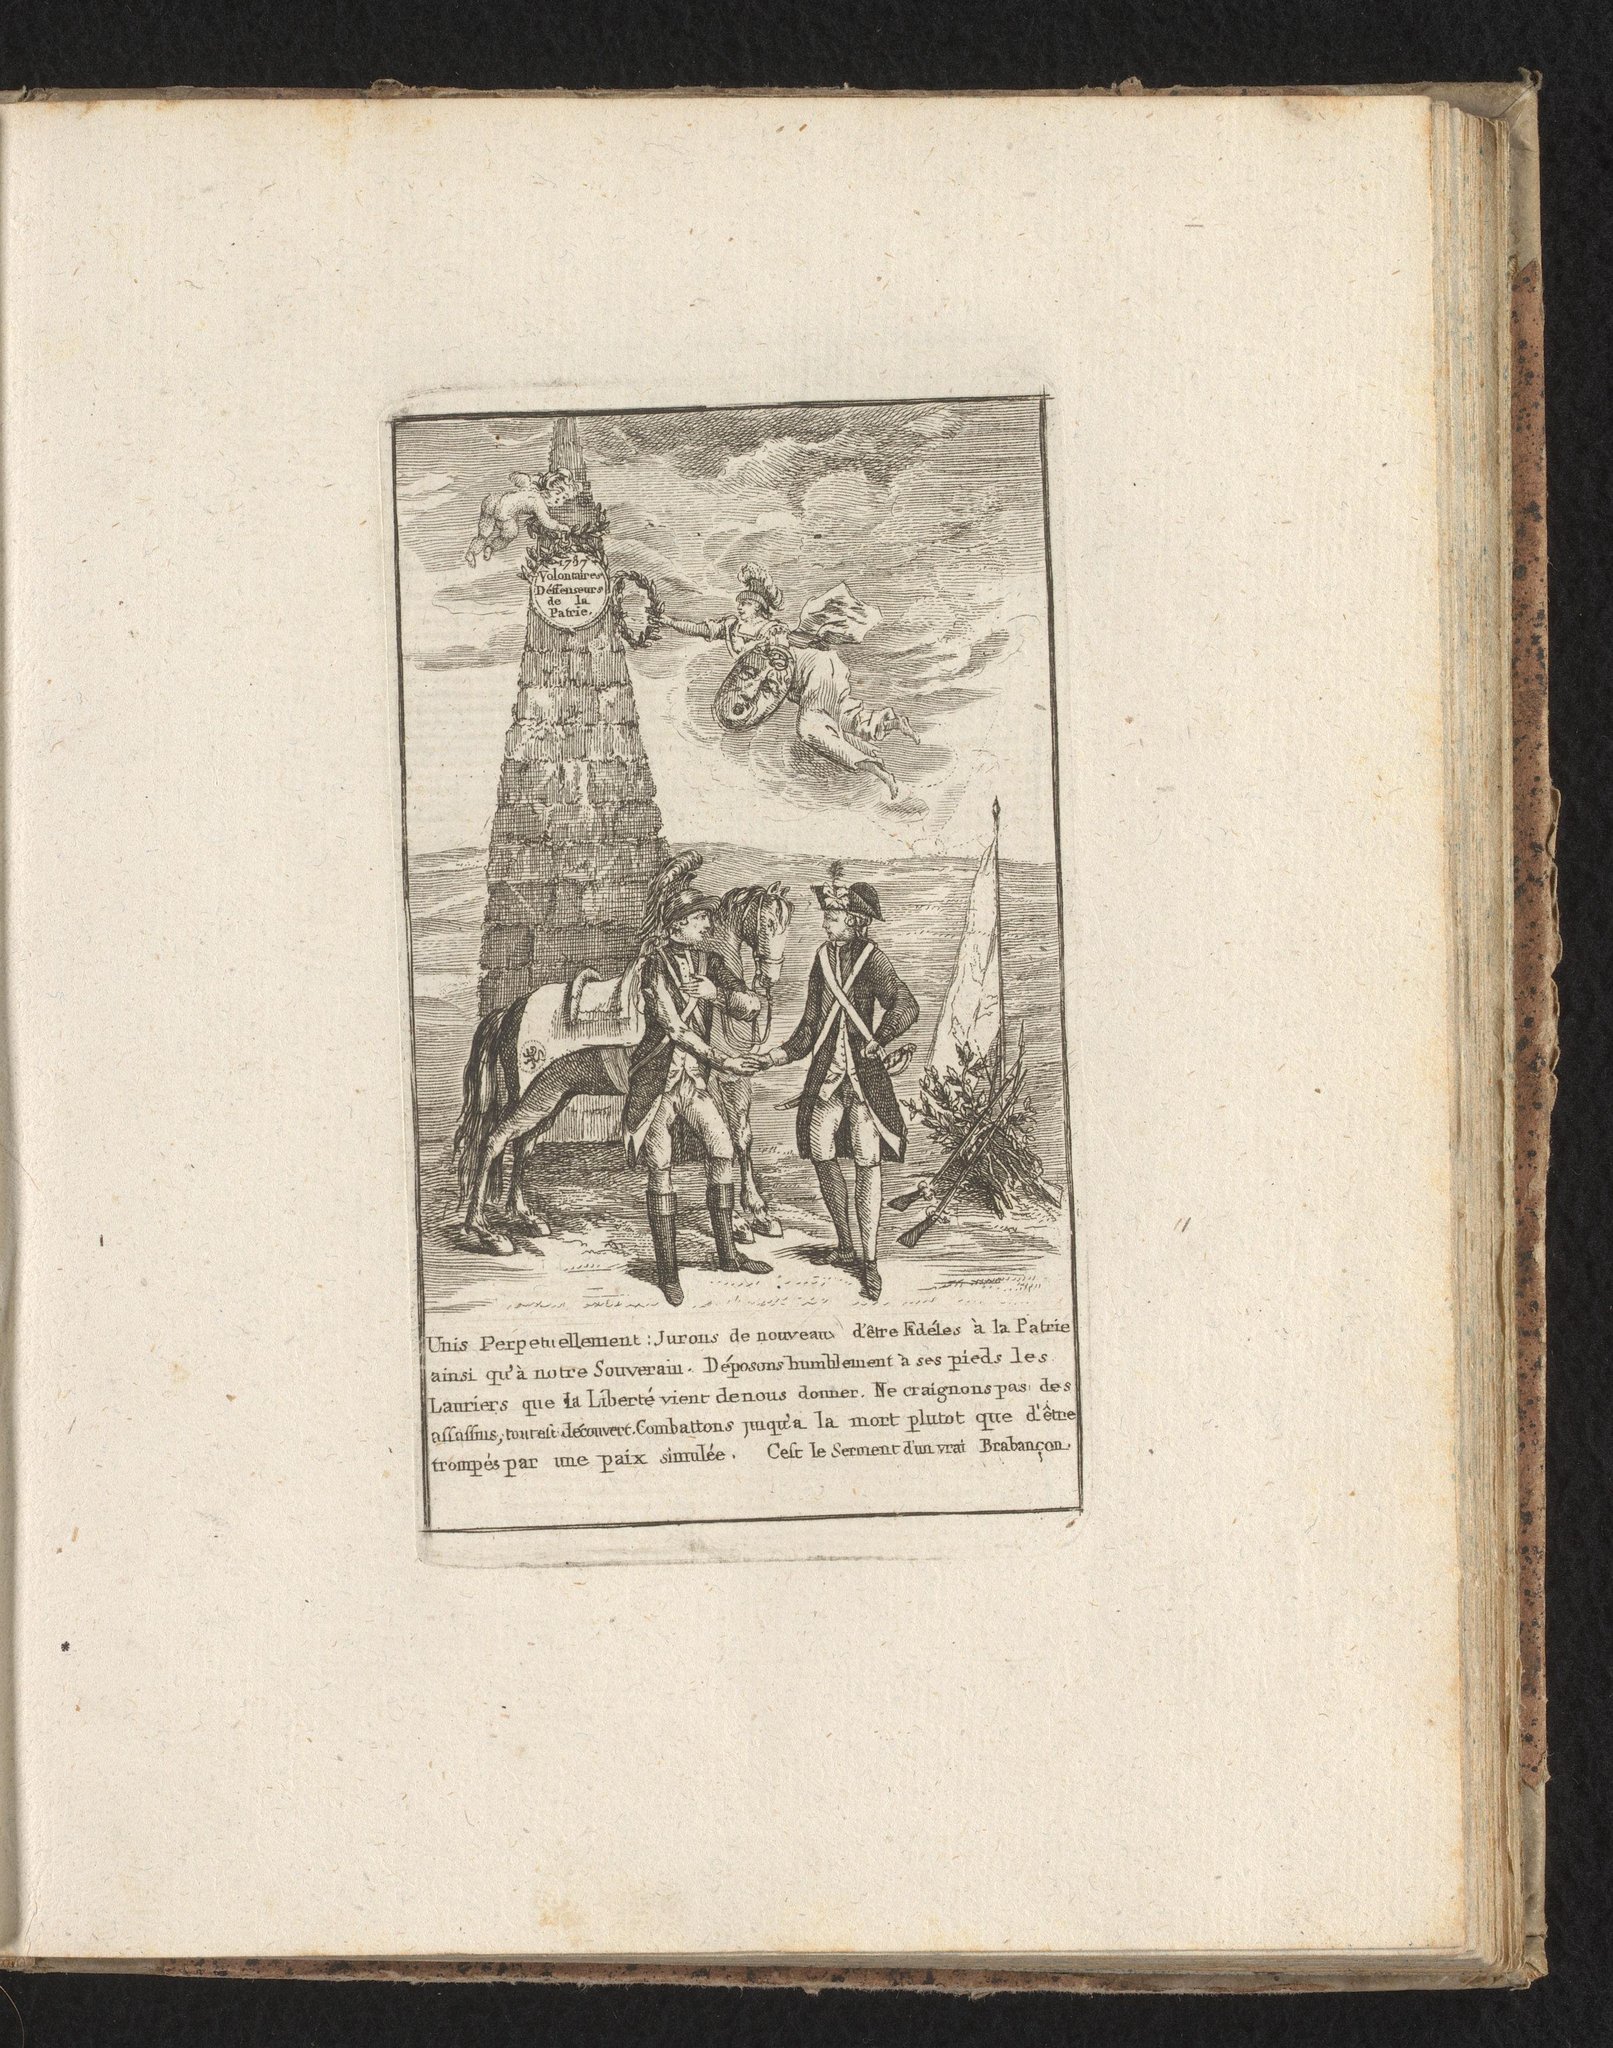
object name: print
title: Monument ter ere van de vrijwillige verdedigers van het Brabantse vaderland, 1787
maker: Anonymous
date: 1787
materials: paper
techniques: engraving, etching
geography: southern netherlands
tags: brabant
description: Allegorie met een monument ter ere van de vrijwillige verdedigers van de vrijheid van het Brabantse vaderland, 1787. Een ruiter en een infanterist geven elkaar de hand voor het monument. Minerva hangt een lauwerkrans aan het monument. Met vijfregelig Frans onderschrift. Onderdeel van de gebundelde verzameling prenten betrekking hebbend op de gebeurtenissen van de Brabantse Omwenteling en de periode 1787-1790.